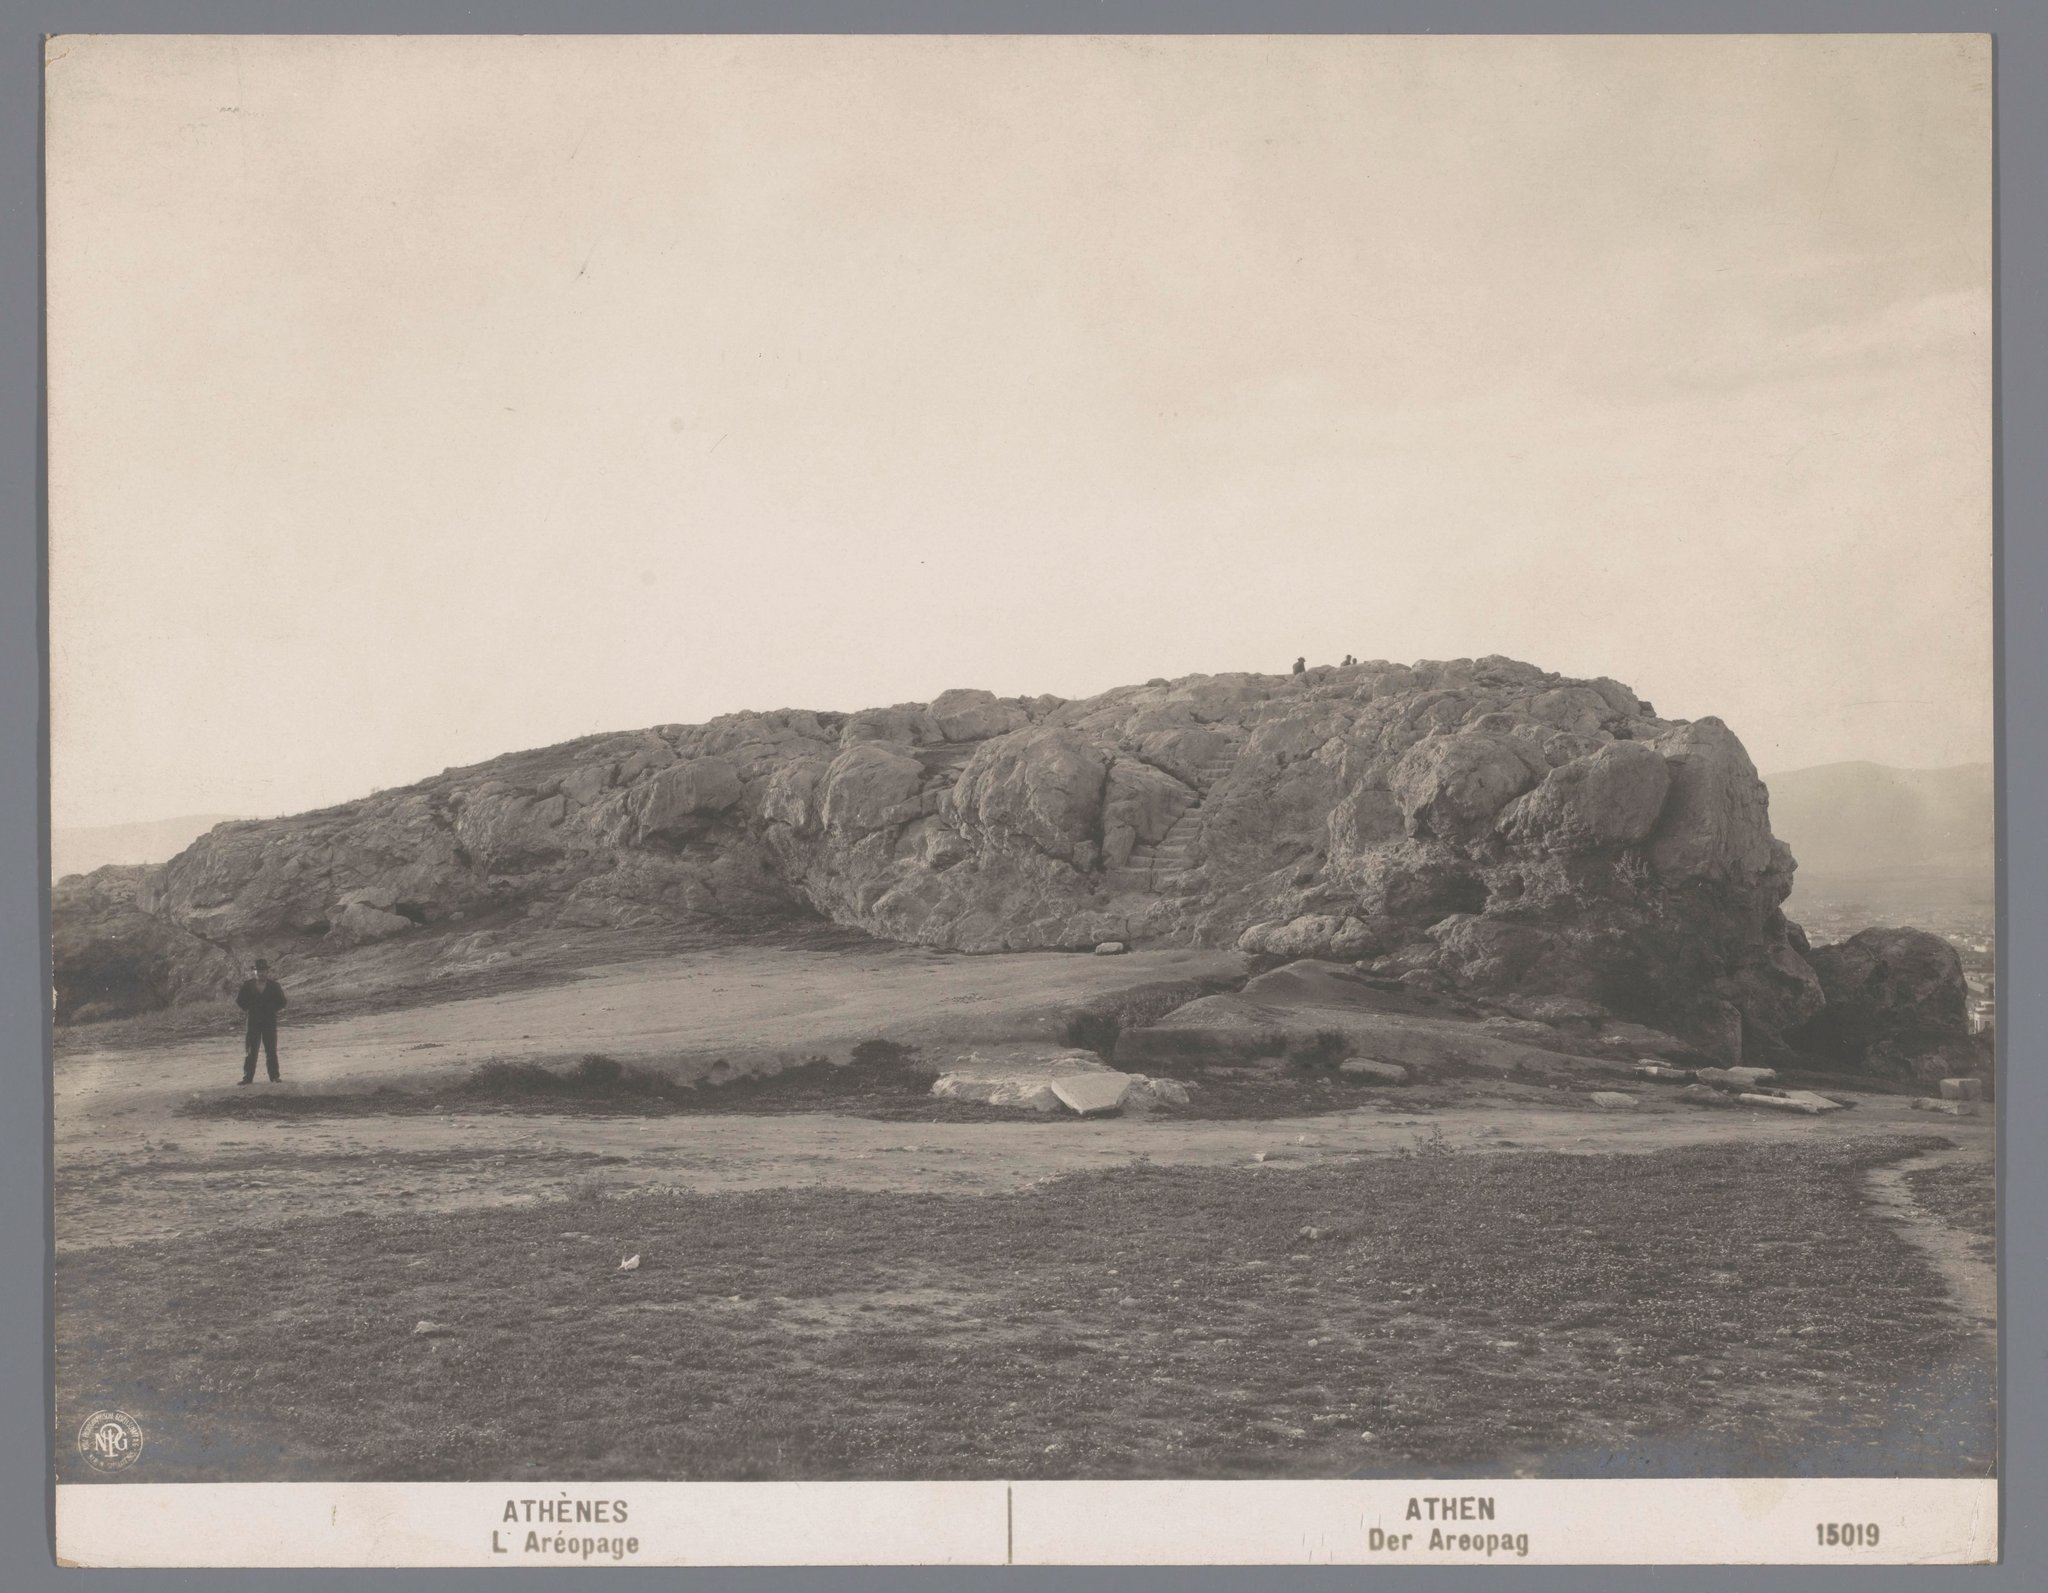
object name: photograph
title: Athènes L'Aréopage / Athen Der Areopag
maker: Anonymous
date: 1905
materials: paper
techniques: gelatin silver print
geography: steglitz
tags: (high) hill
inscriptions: collector's mark: ‘Vosmaer’, inscription: ‘Neue Photographische Gesellschaft A.G./ Berlin Steglitz 1905/ NPG’, number: ‘15019’, stamp: ‘II. WAHL’